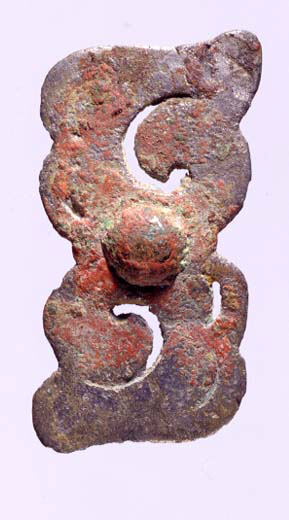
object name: belt ornament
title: Belt Ornament with Zoomorphic Design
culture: chinese or mongolian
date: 600-401 BCE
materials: bronze